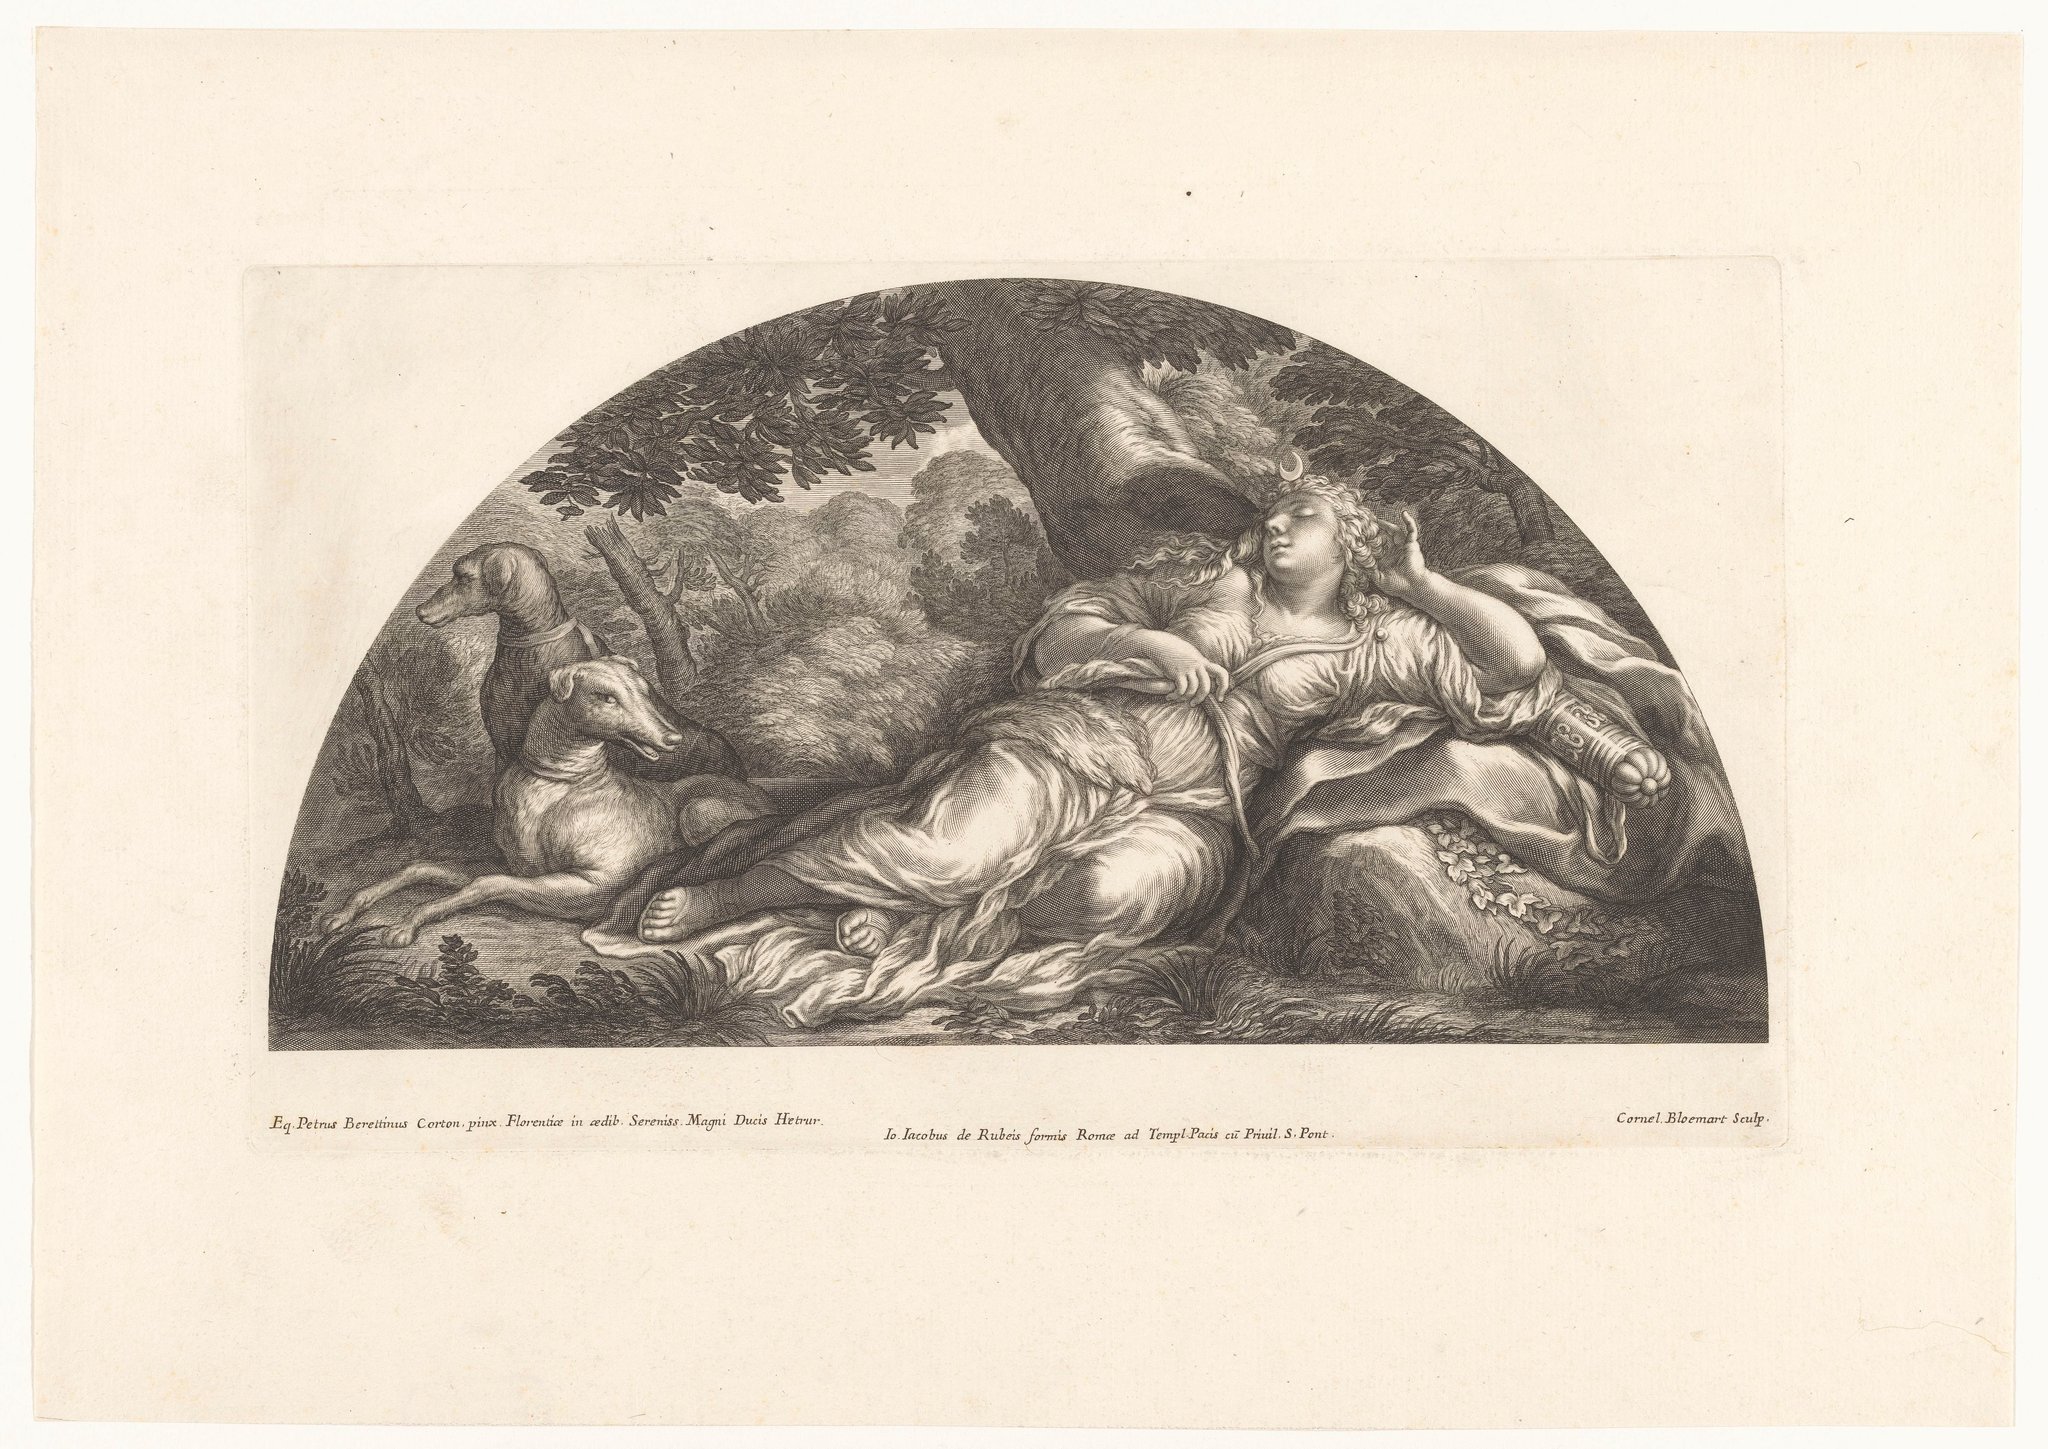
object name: print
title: Voorstellingen van heroïsche daden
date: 1677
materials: paper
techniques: engraving, etching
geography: vatican city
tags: (story of) diana (artemis), sleeping; unconsciousness - bb - out of doors, hunting dogs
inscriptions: collector's mark: Lugt 11, collector's mark: ‘Hinloopen’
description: Naar een fresco door Pietro da Cortona in de Sala di Venere in Palazzo Pitti te Florence. De prent maakt deel uit van een reeks van 15 ongenummerde prenten. Deze prent maakte oorspronkelijk deel uit van liber nr. 22 van de Atlas van Rome, uit de collectie Hinloopen. In dit album waren een aantal prentreeksen naar bekende zeventiende eeuwse frescoseries bijeengebonden. In 1709 heeft Schijnvoet op last van de burgemeesters van Amsterdam de collectie herordend. De prenten uit liber 22 kwamen terrecht in Schijnvoet boek nr. 10. De laatst gedateerde reeks in het album is gedateerd 1691. Het album moet dus na deze datum gebonden zijn. De band is in de Rijksakademietijd uit elkaar gehaald. De marges van de prenten zijn bij het opbergen in het Rijksprentenkabinet vaak drastisch afgesneden. Van een aantal series waren de prenten teruggeslagen om in het album te passen. (Zie: Waals, Jan van der. De prentschat van Michiel Hinloopen. 's-Gravenhage: SDU uitgeverij, 1988, pp. 173-174.)